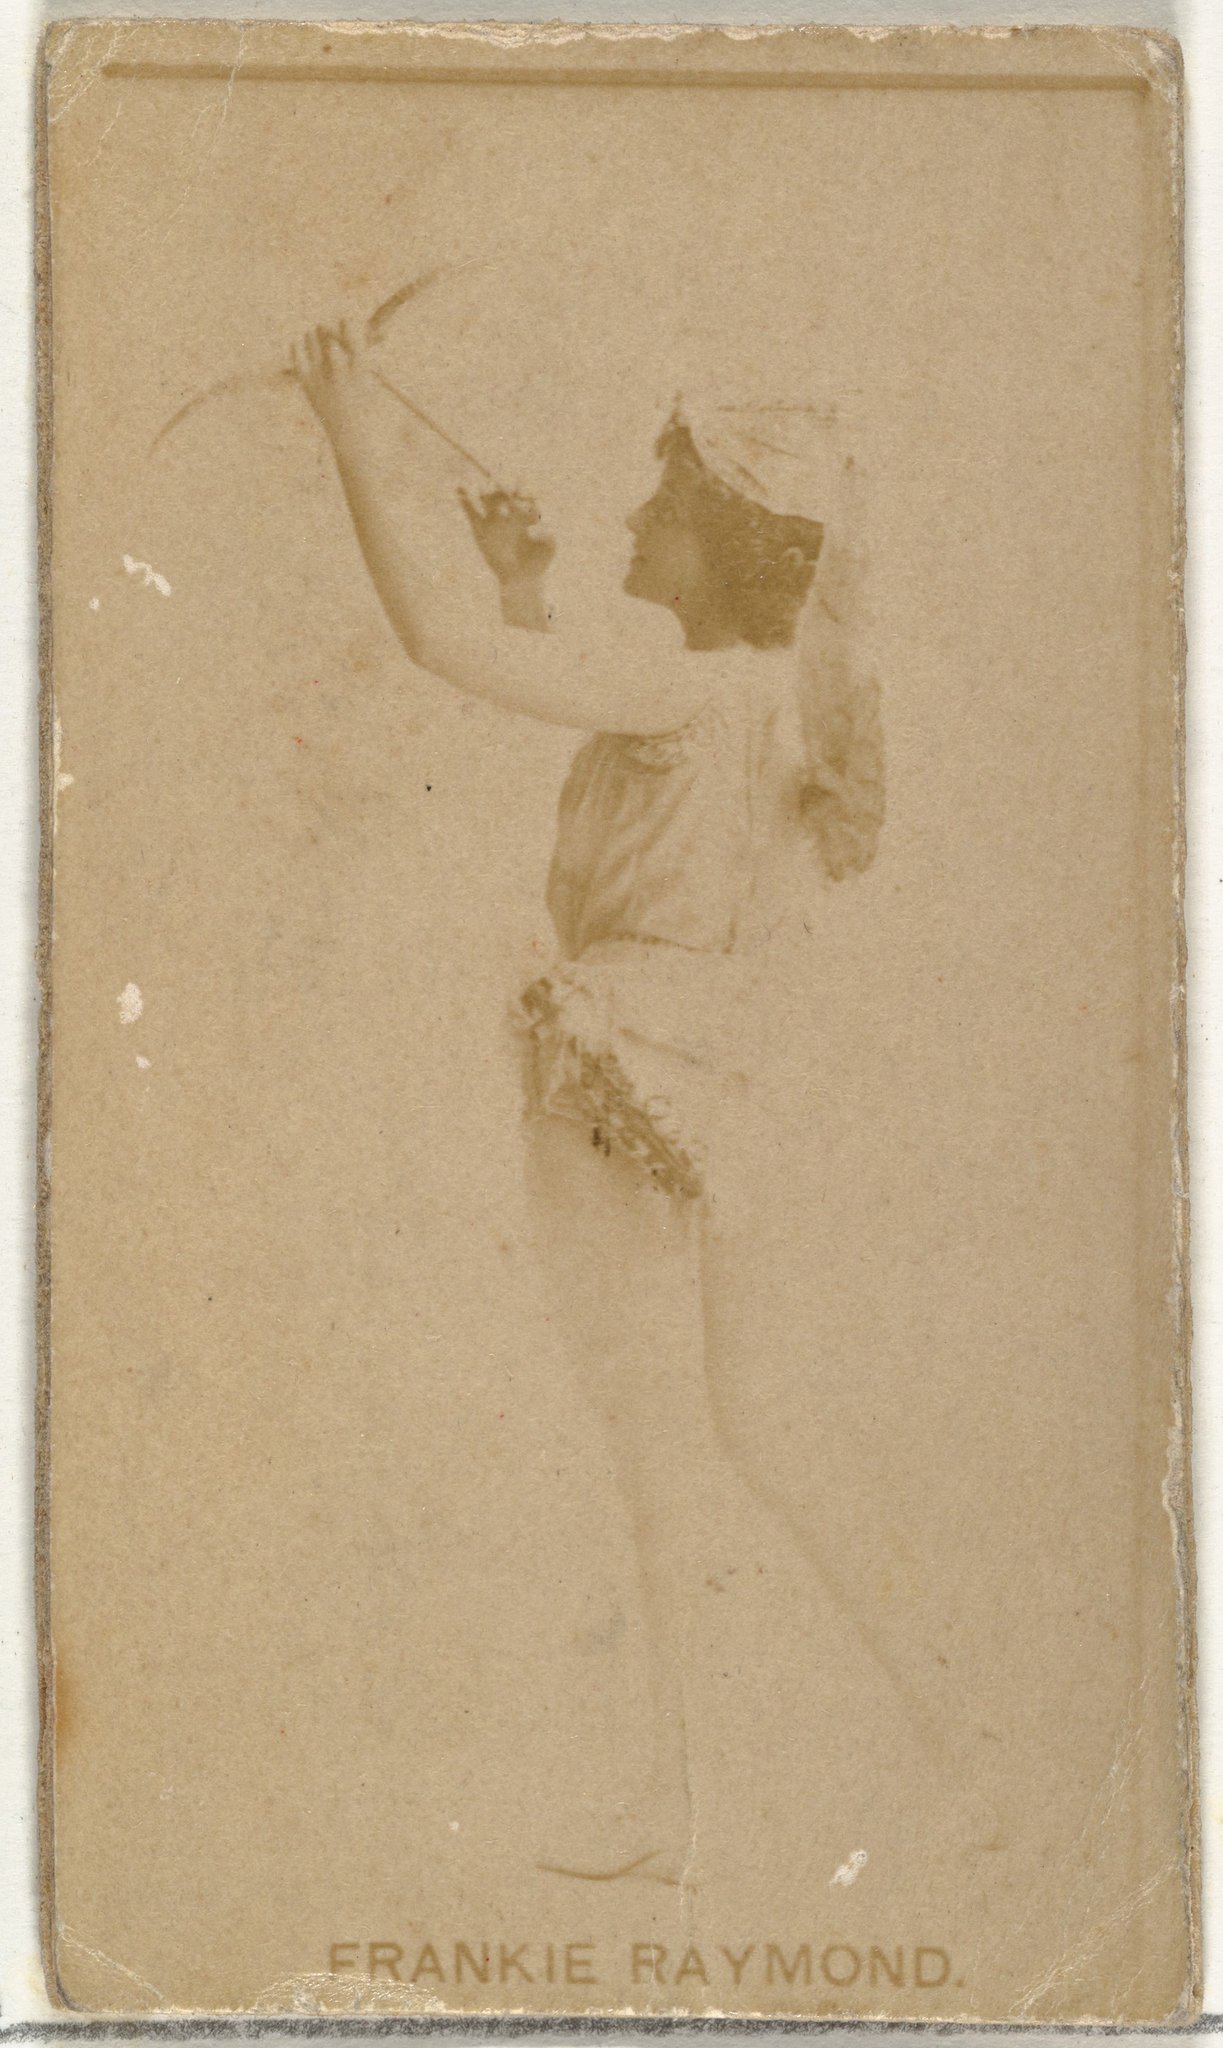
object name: photograph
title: Frankie Raymond, from the Actors and Actresses series (N145-8) issued by Duke Sons & Co. to promote Duke Cigarettes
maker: w. duke, sons & co.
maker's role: publisher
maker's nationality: american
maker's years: 1870-1920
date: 1891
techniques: albumen silver print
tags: portraits,women,actresses